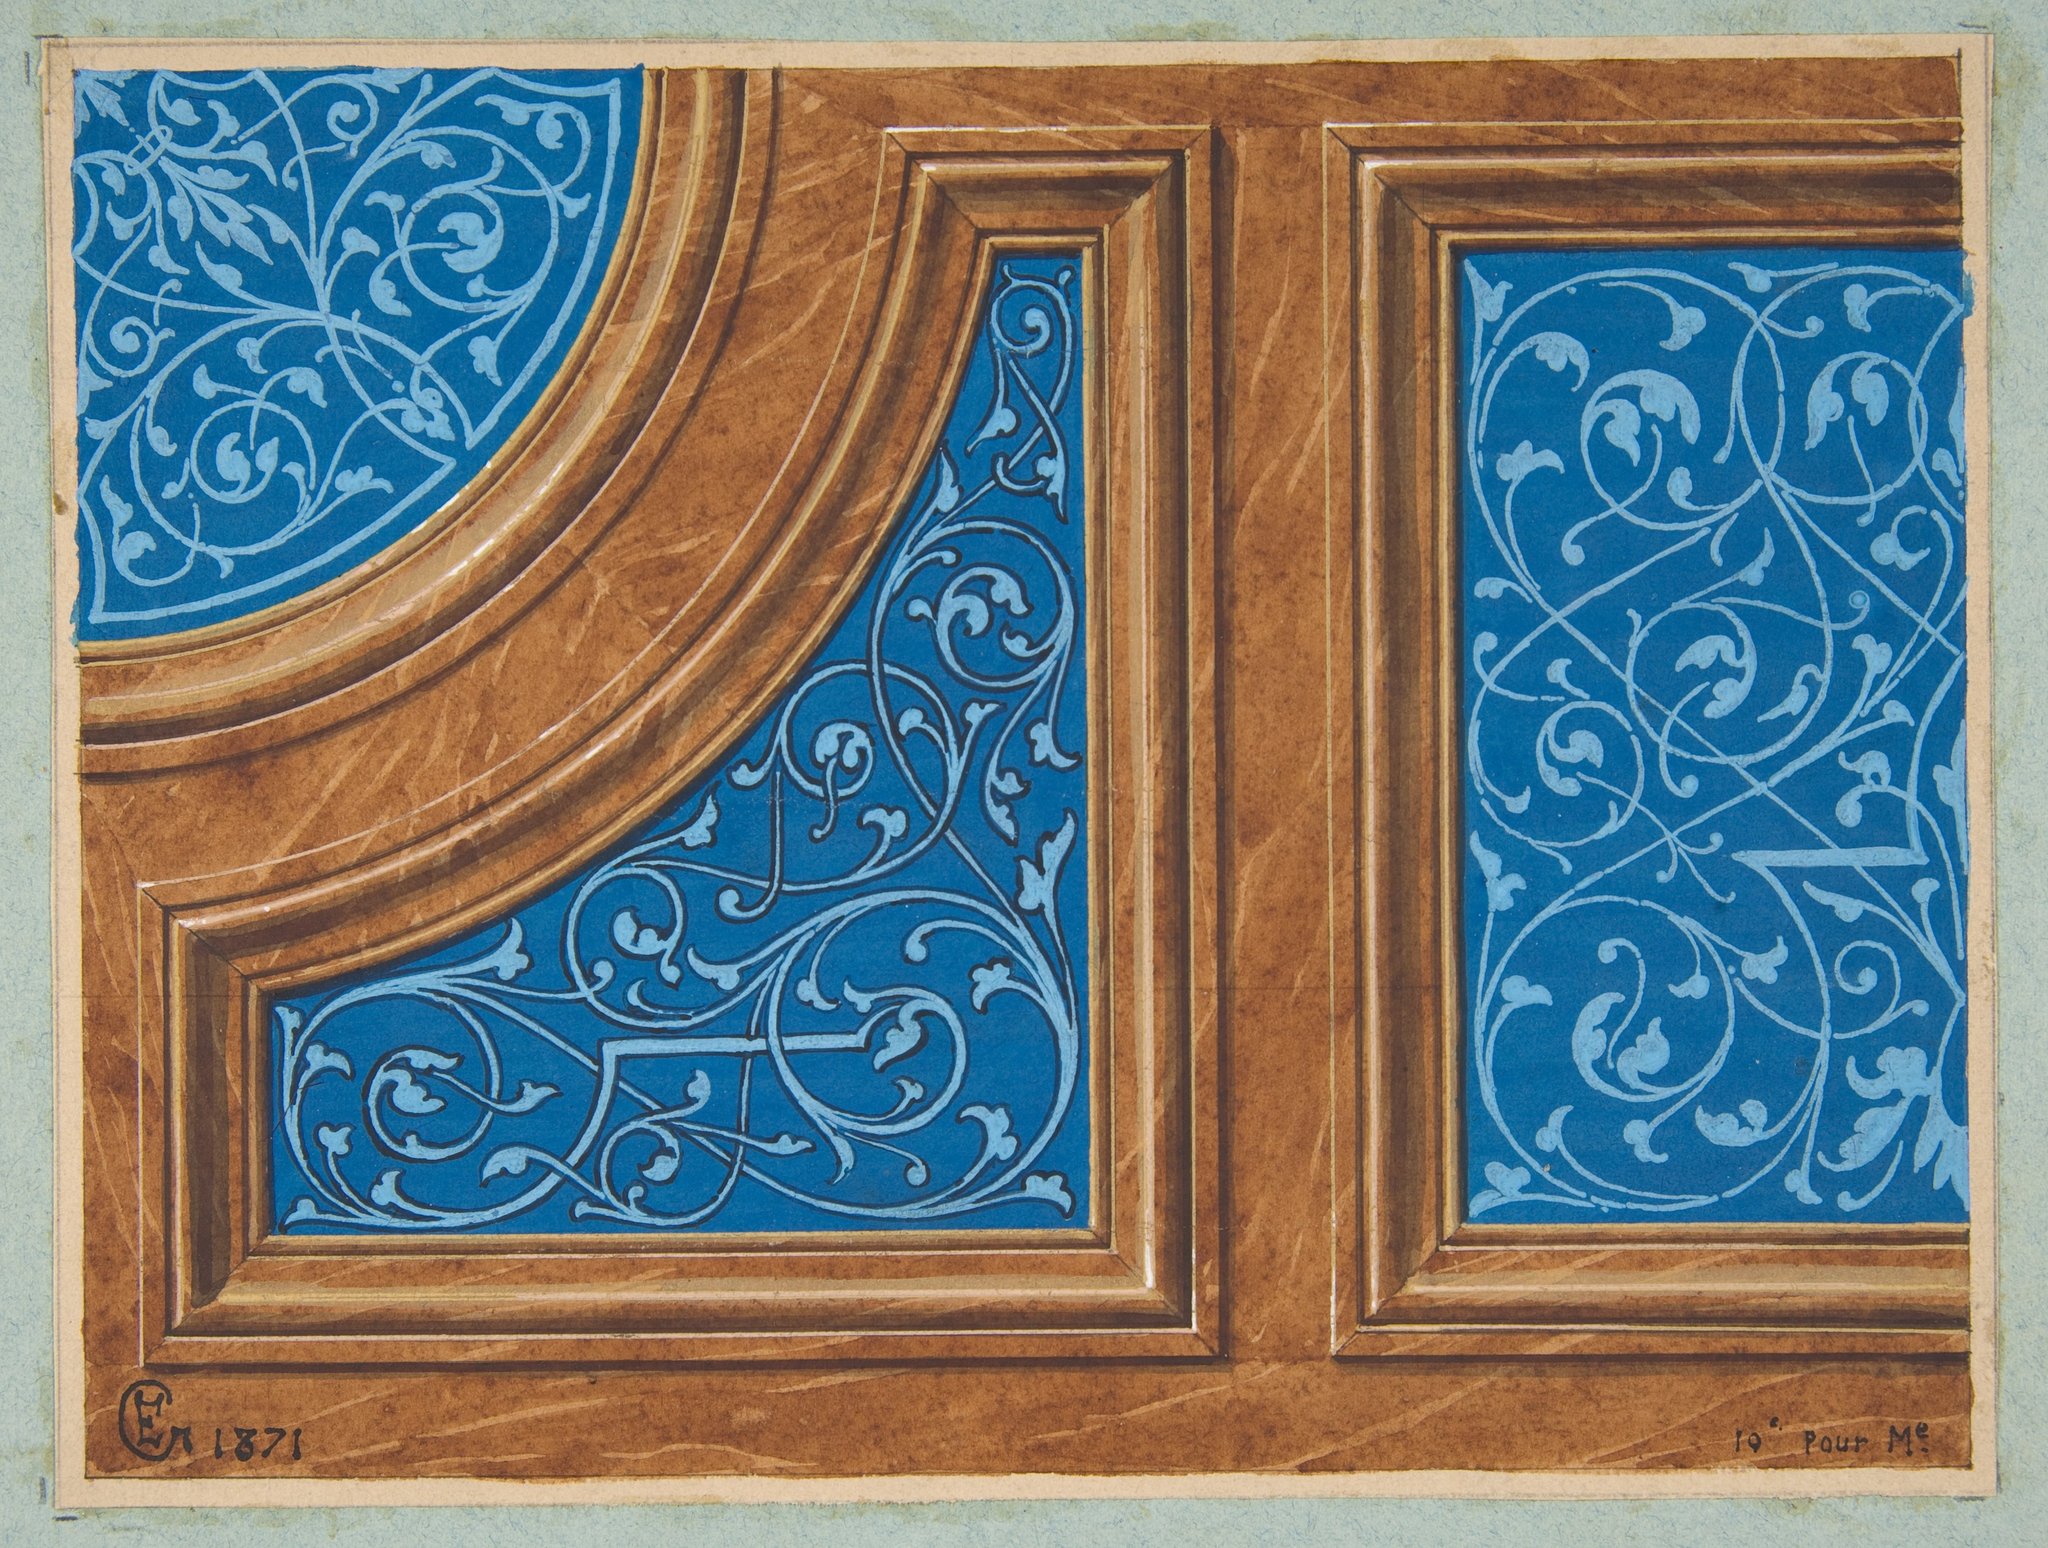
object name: drawing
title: Partial design for wood panneling inlaid with painted panels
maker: jules-edmond-charles lachaise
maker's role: artist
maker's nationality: french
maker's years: 1897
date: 1871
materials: gouache, ink, watercolor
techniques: pen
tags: ornament